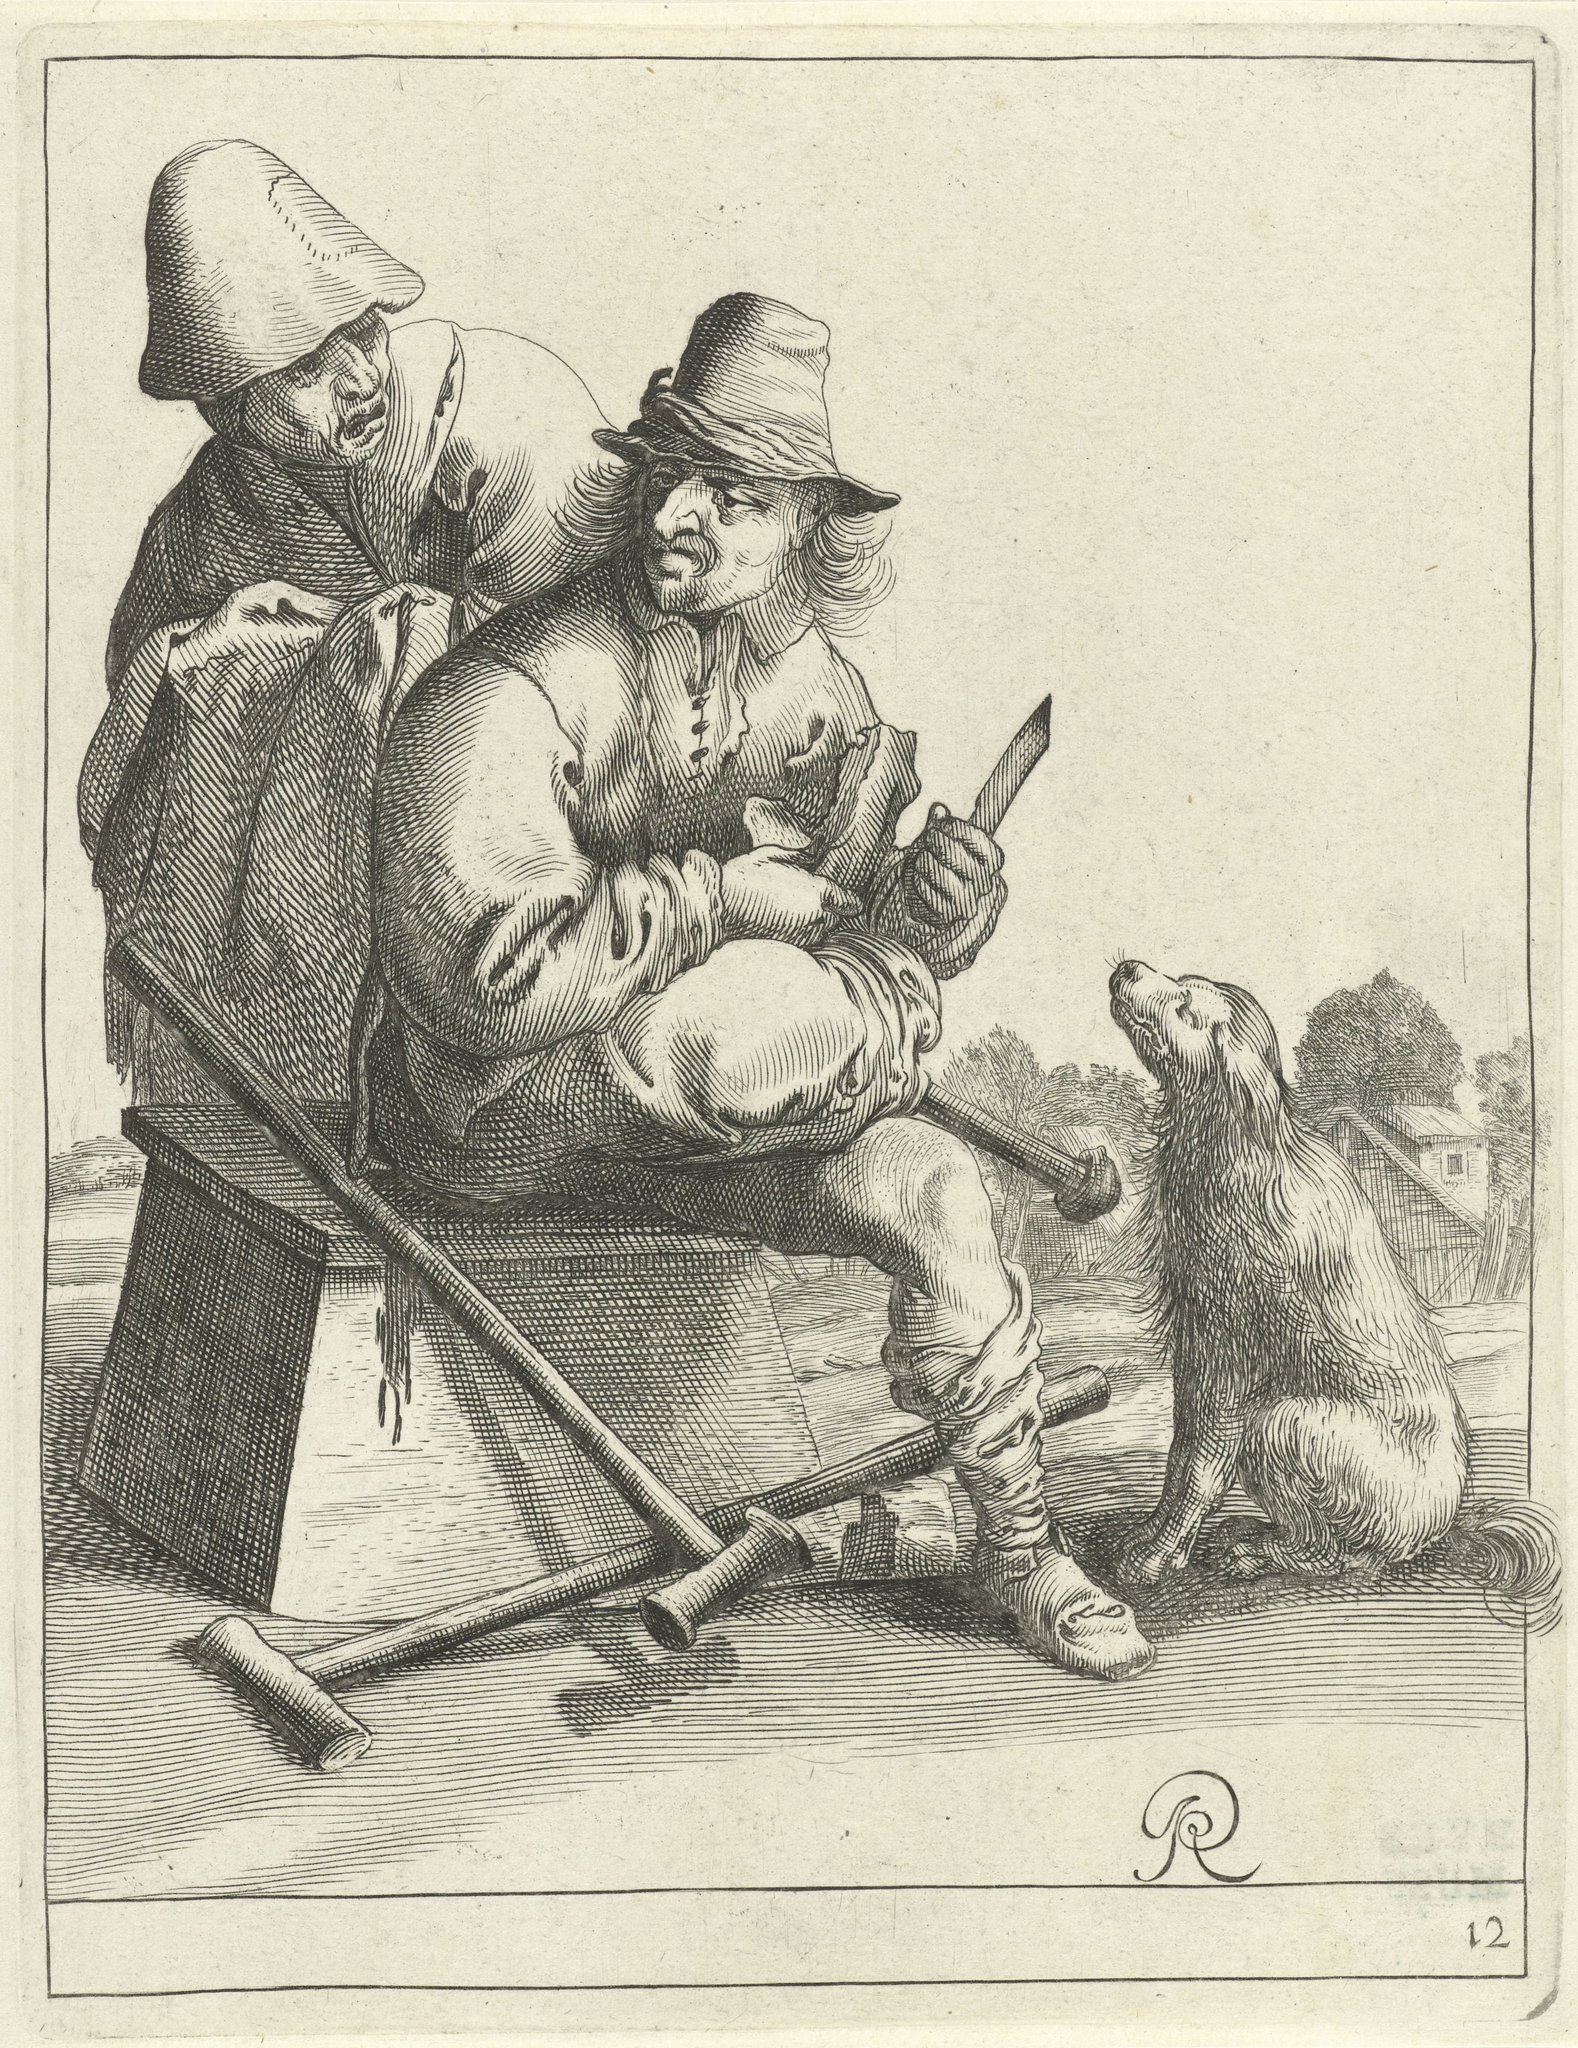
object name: print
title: Twee bedelaars en een hond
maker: pieter jansz quast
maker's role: draughtsman, painter, print maker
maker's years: 1605-1647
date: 1634-1638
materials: paper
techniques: engraving, etching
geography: the hague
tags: crutches, wooden leg, beggar, tools, aids, implements ~ crafts and industries: knife, dog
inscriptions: collector's mark: Lugt 2165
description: Een bedelaar met een houten been zit op een blok en snijdt vlees of brood met een mes. Achter hem staat een andere landloper en voor hem zit een hond die de neus in de richting van het voedsel houdt. De prent maakt deel uit van een serie van zesentwintig prenten met bedelaars en boeren.